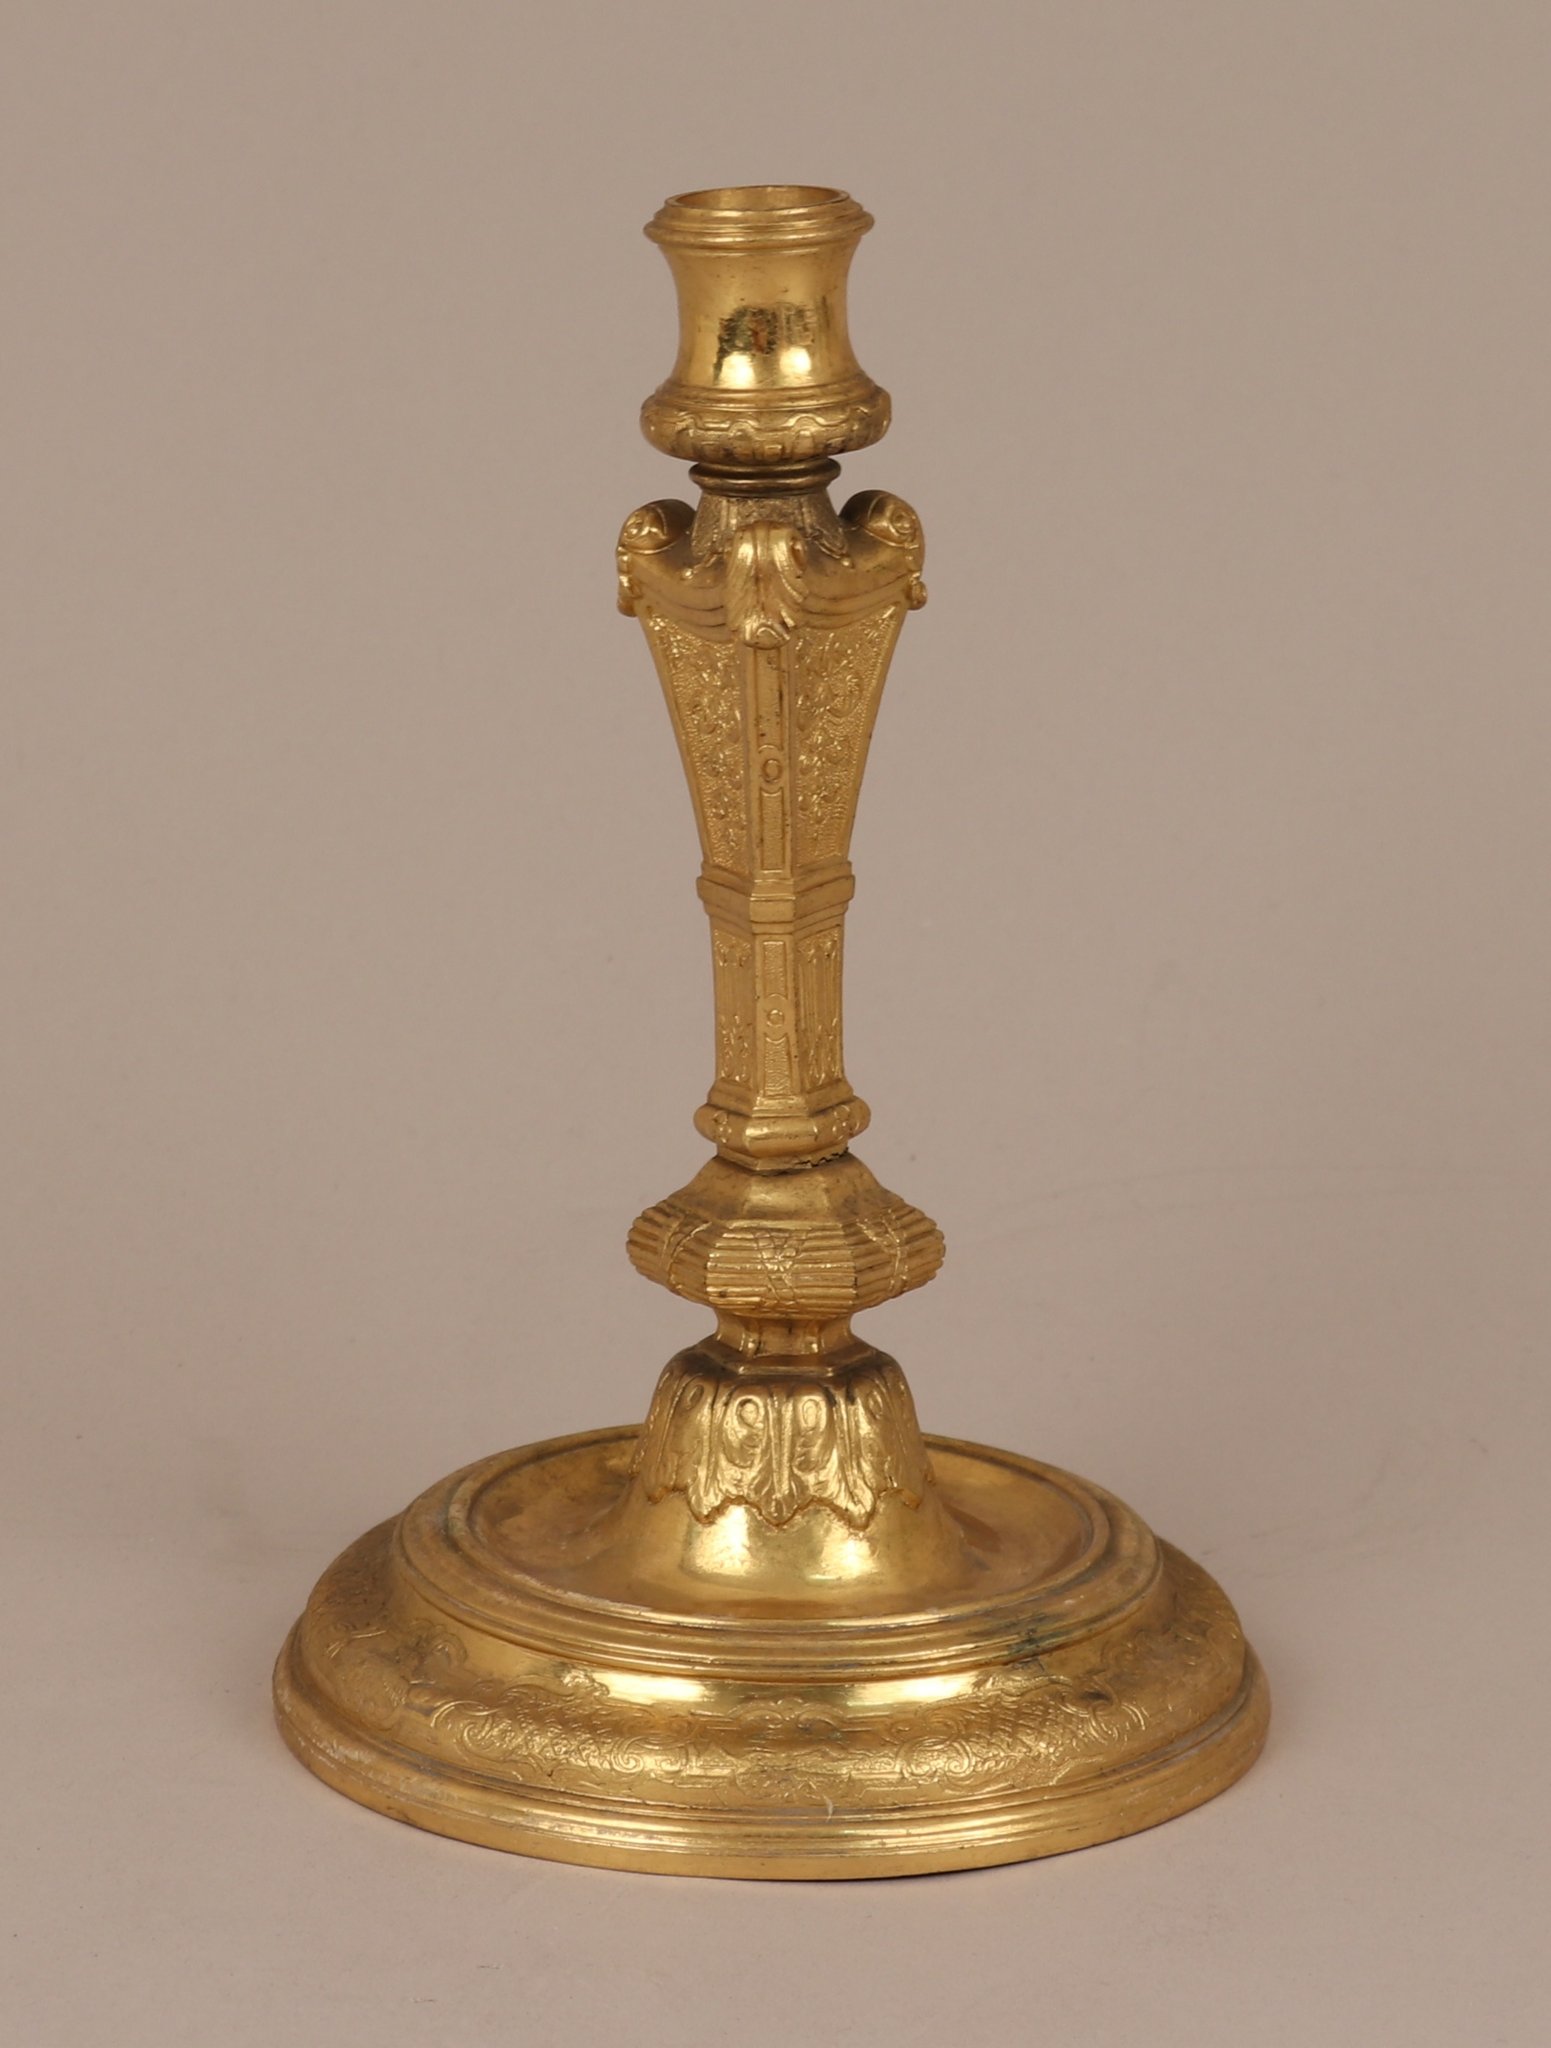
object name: candlestick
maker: johann ludwig ii biller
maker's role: maker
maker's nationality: german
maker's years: 1692-1746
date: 1801-1900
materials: gold, metal